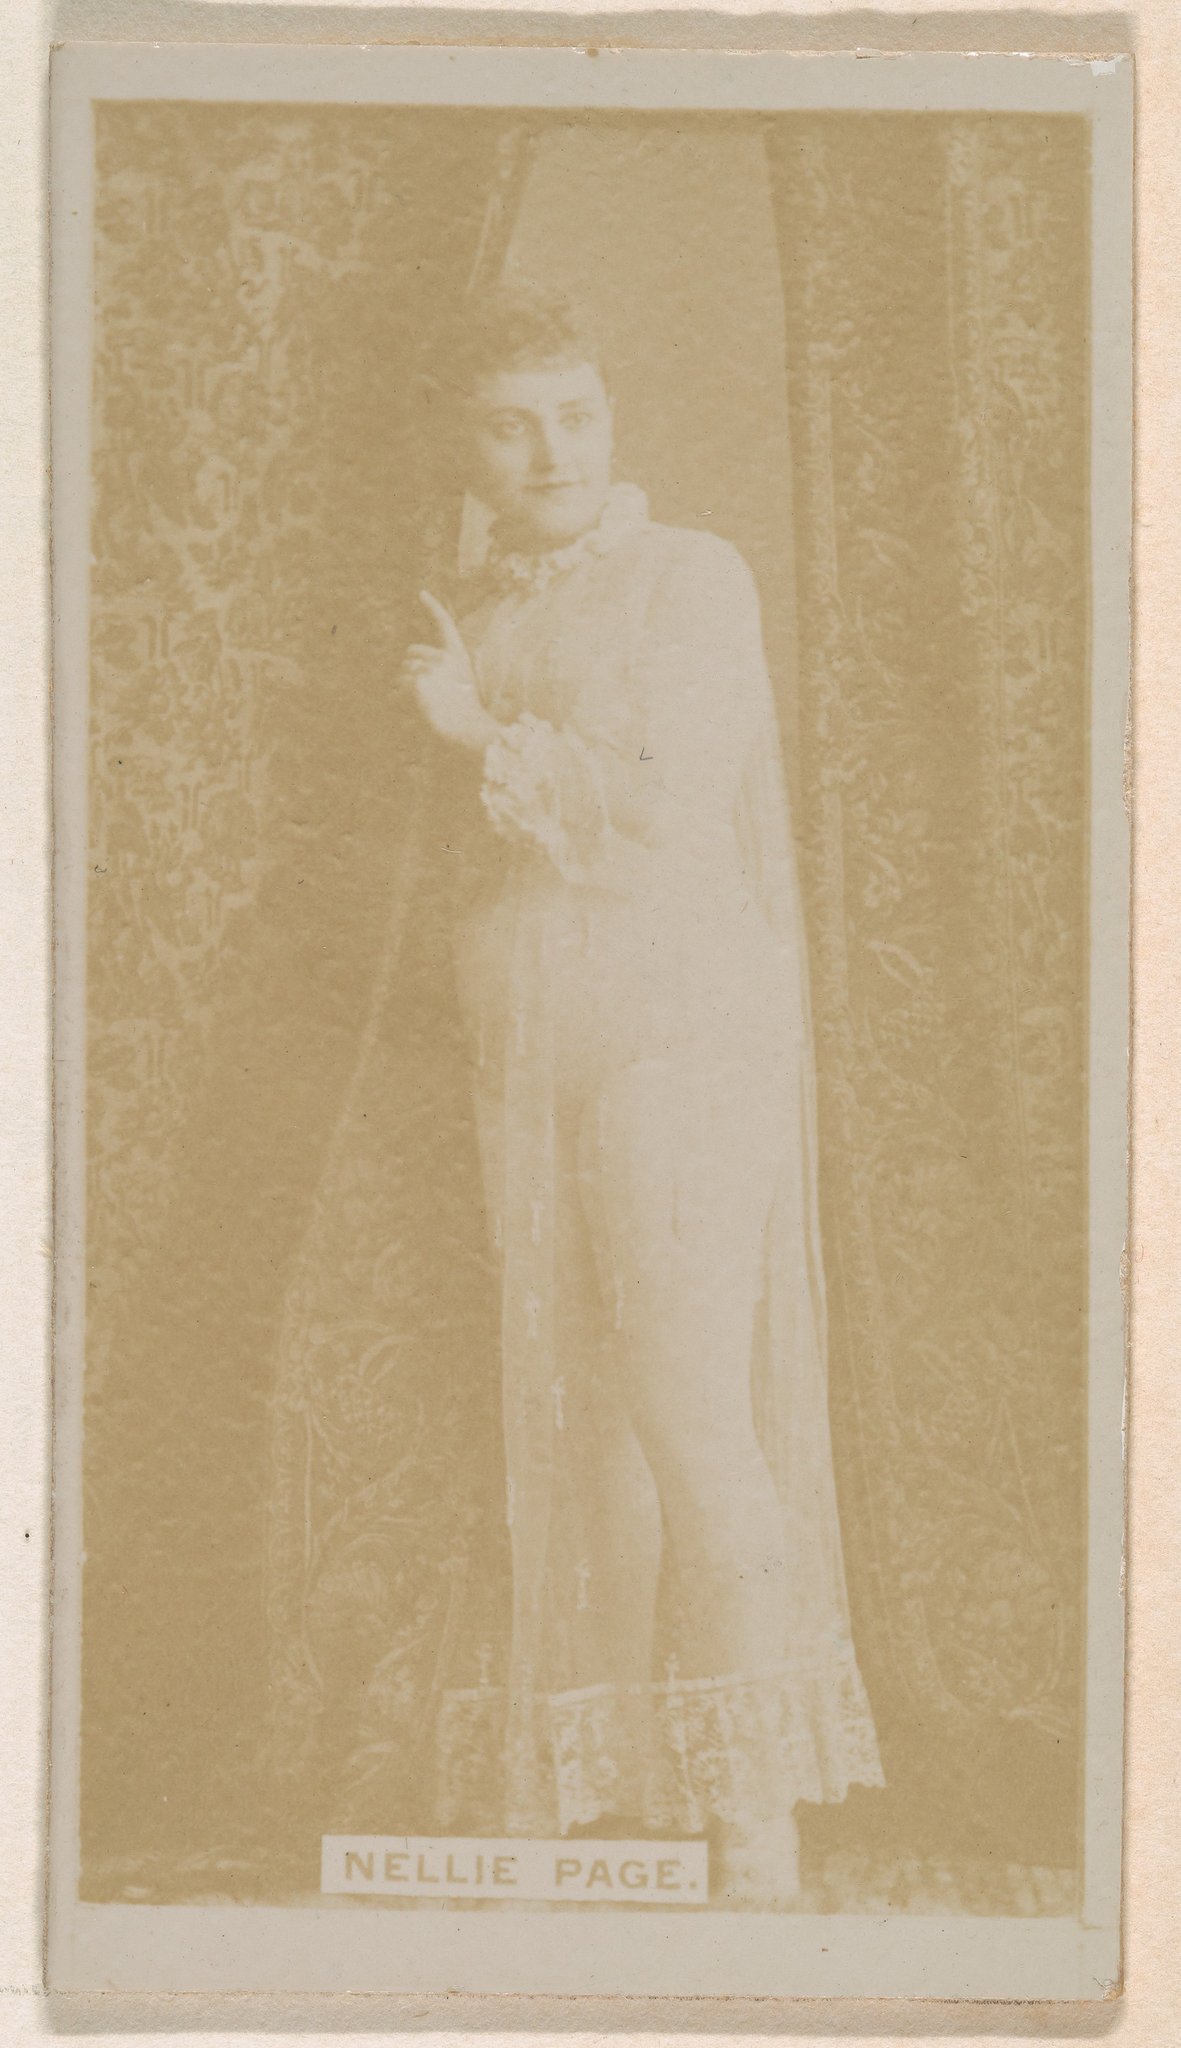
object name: photograph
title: Nellie Page, from the Actresses series (N245) issued by Kinney Brothers to promote Sweet Caporal Cigarettes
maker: kinney brothers tobacco company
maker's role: publisher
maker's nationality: american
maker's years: 1869-2011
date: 1890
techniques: albumen silver print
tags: portraits,women,actresses